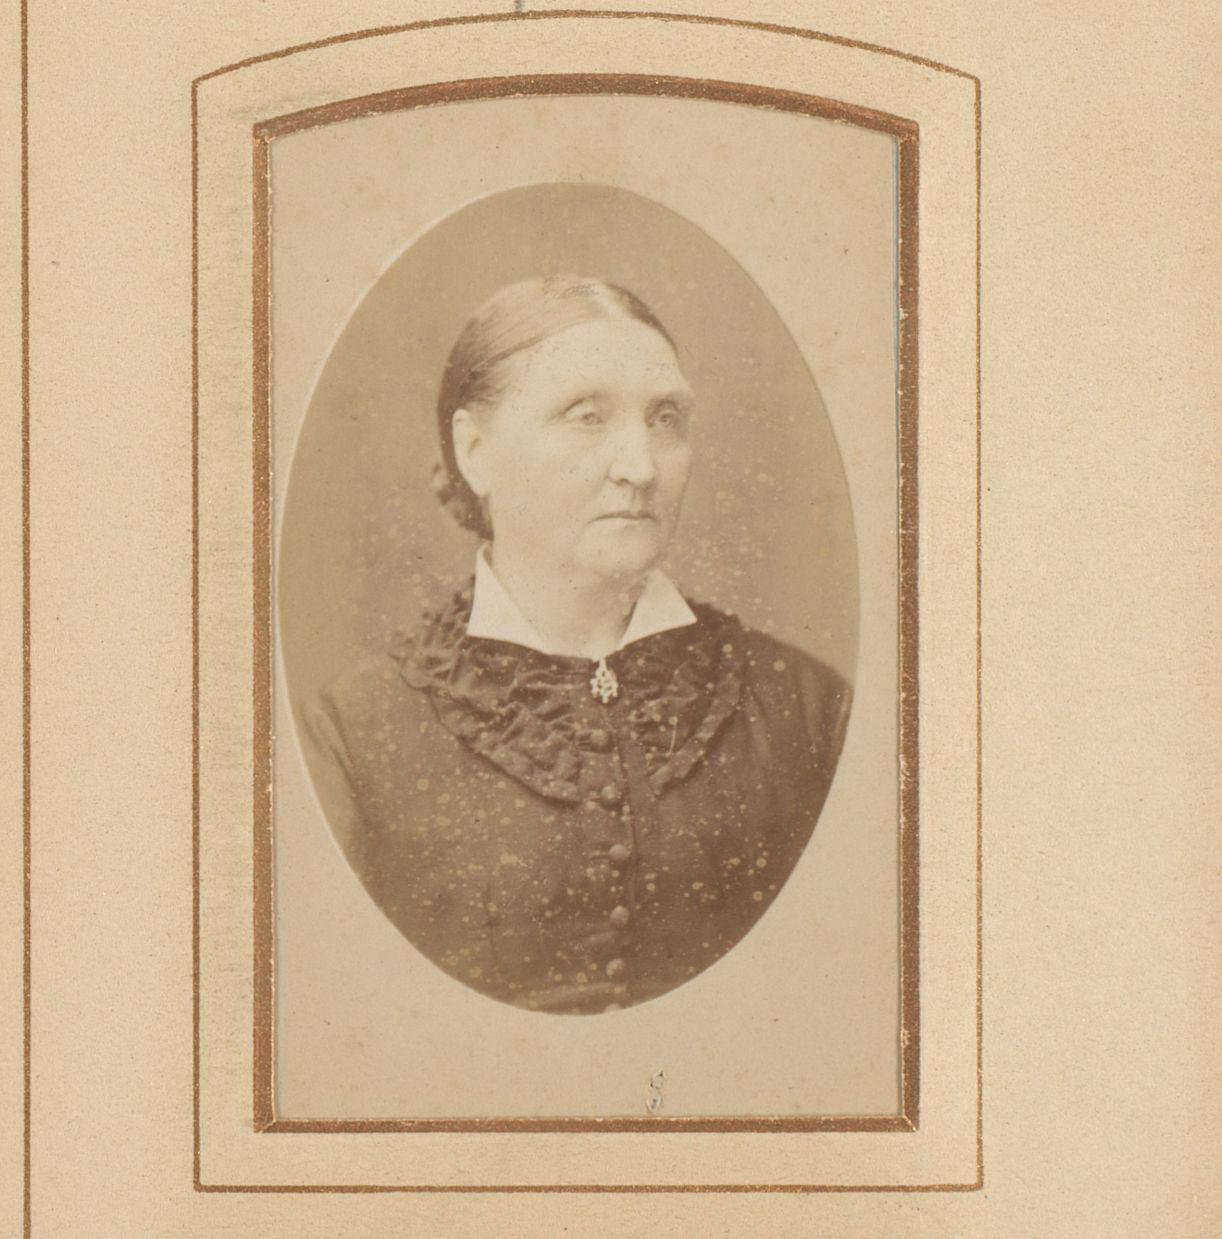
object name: photograph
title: Portret van een oude vrouw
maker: Anonymous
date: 1870-1900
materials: cardboard, photographic support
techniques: albumen print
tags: historical persons - bb - woman, old woman